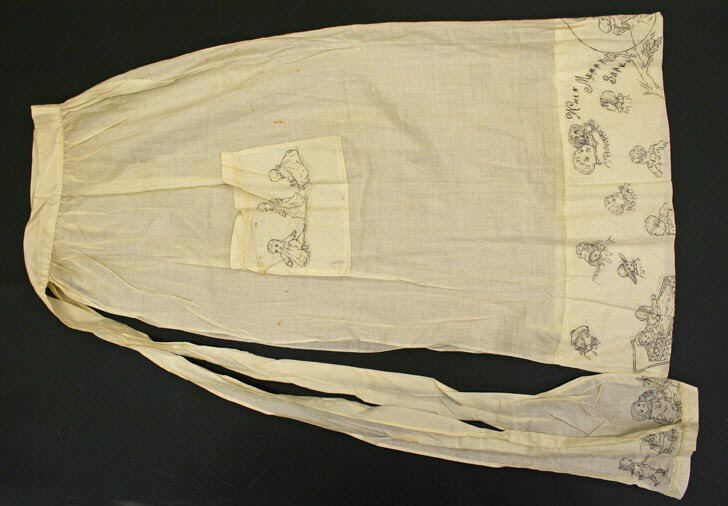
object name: apron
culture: american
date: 1880-1889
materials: cotton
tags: infants